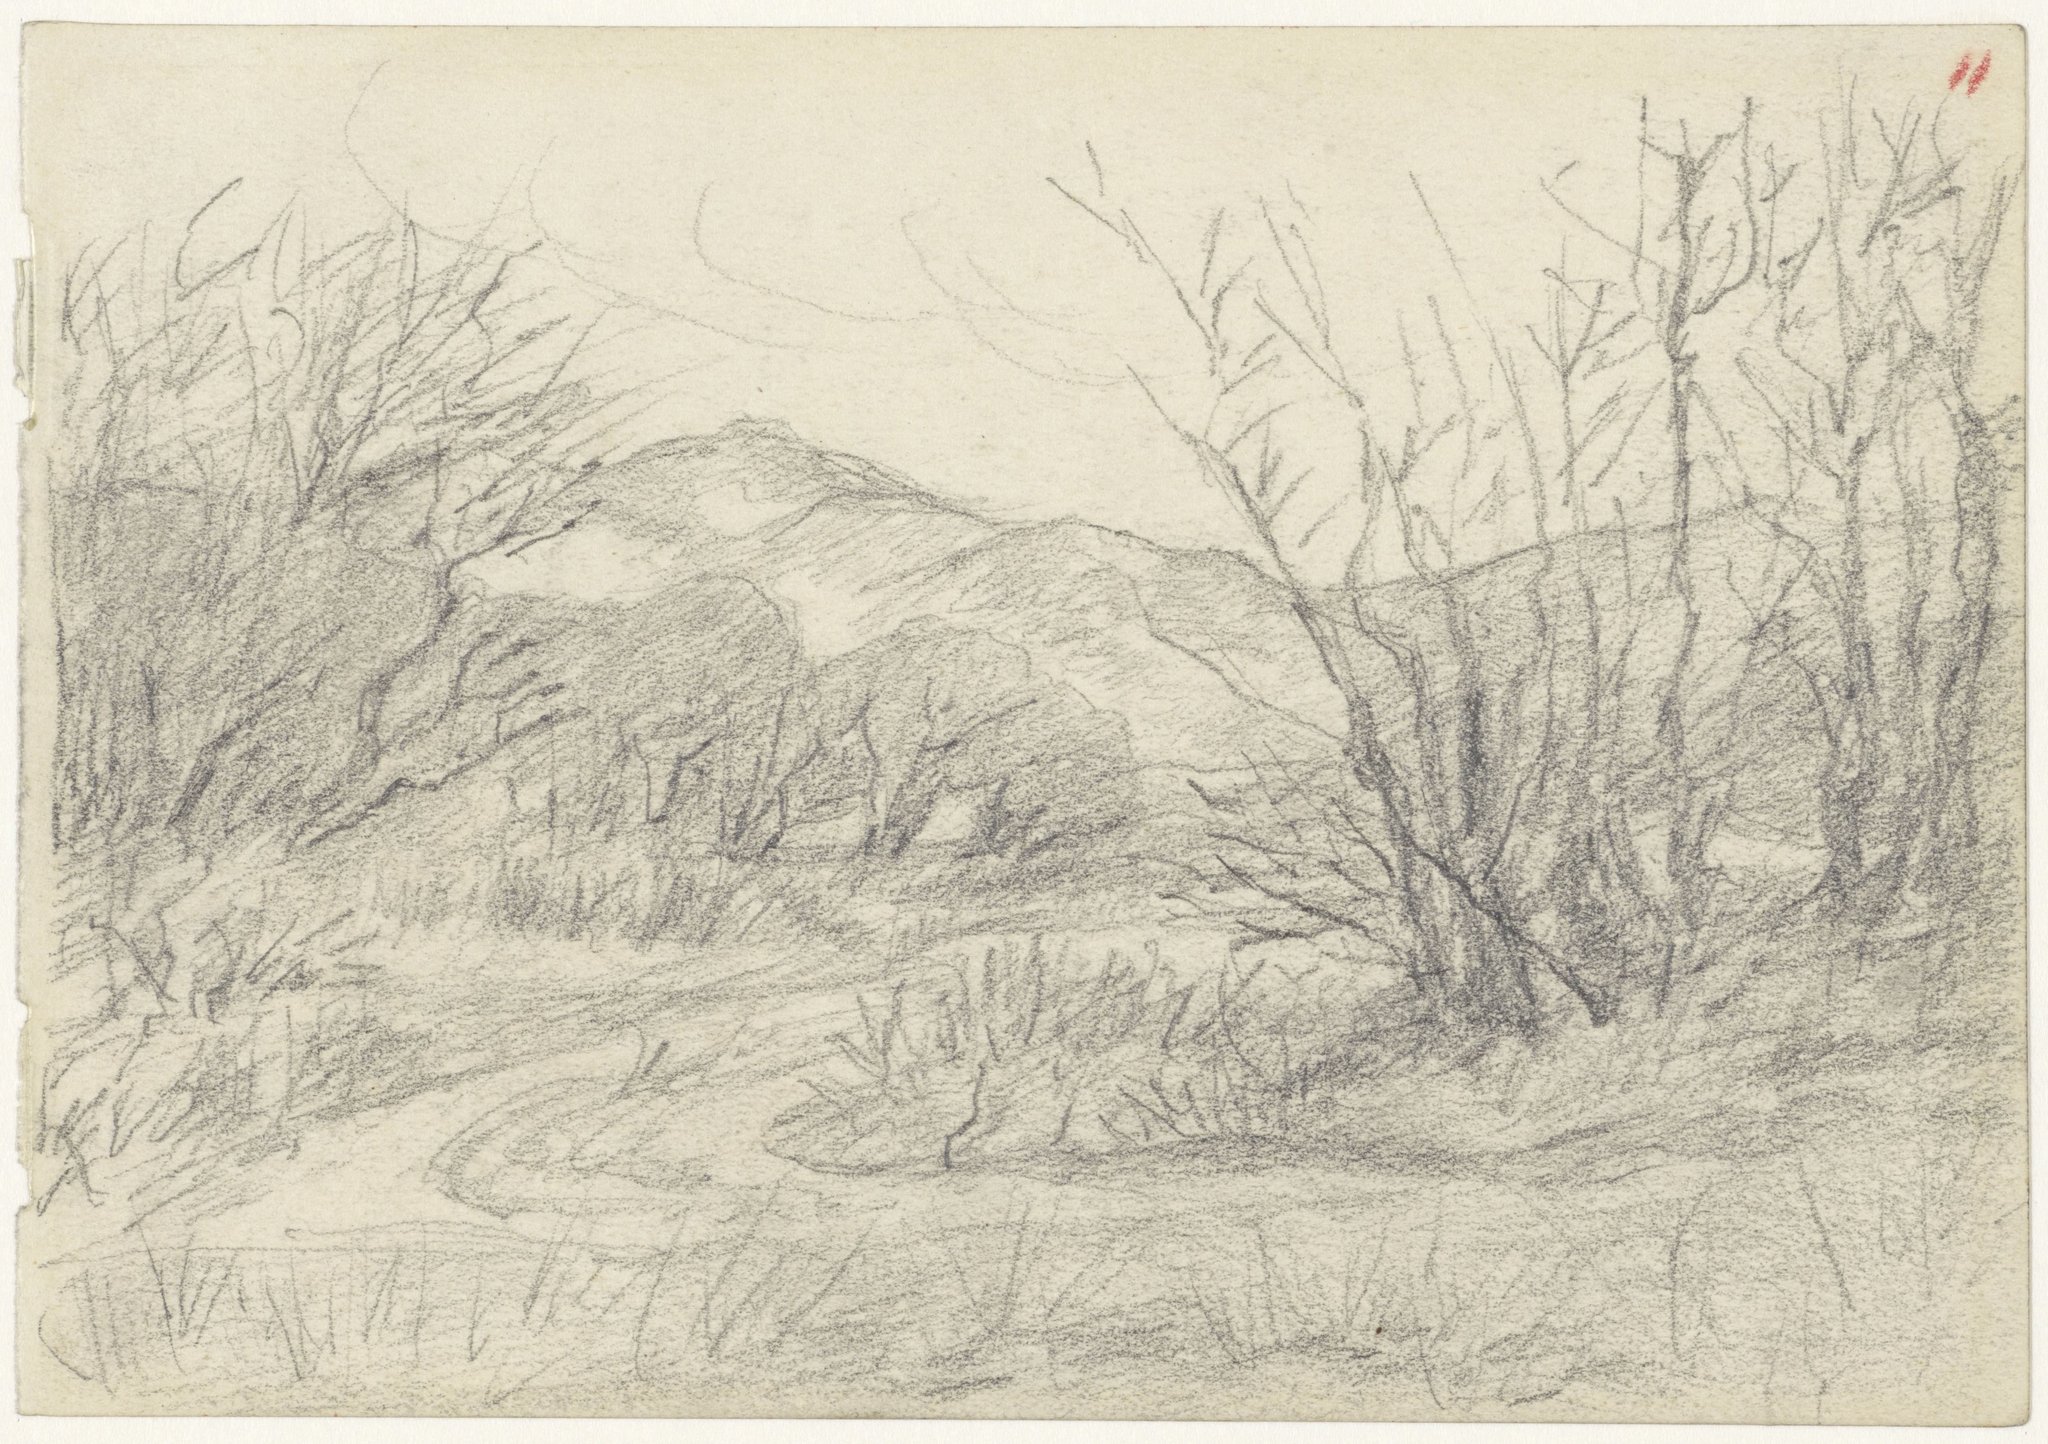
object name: drawing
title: Weg in een heuvellandschap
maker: jozef israëls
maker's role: draughtsman, painter, print maker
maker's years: 1824-1911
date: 1834-1911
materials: paper, pencil